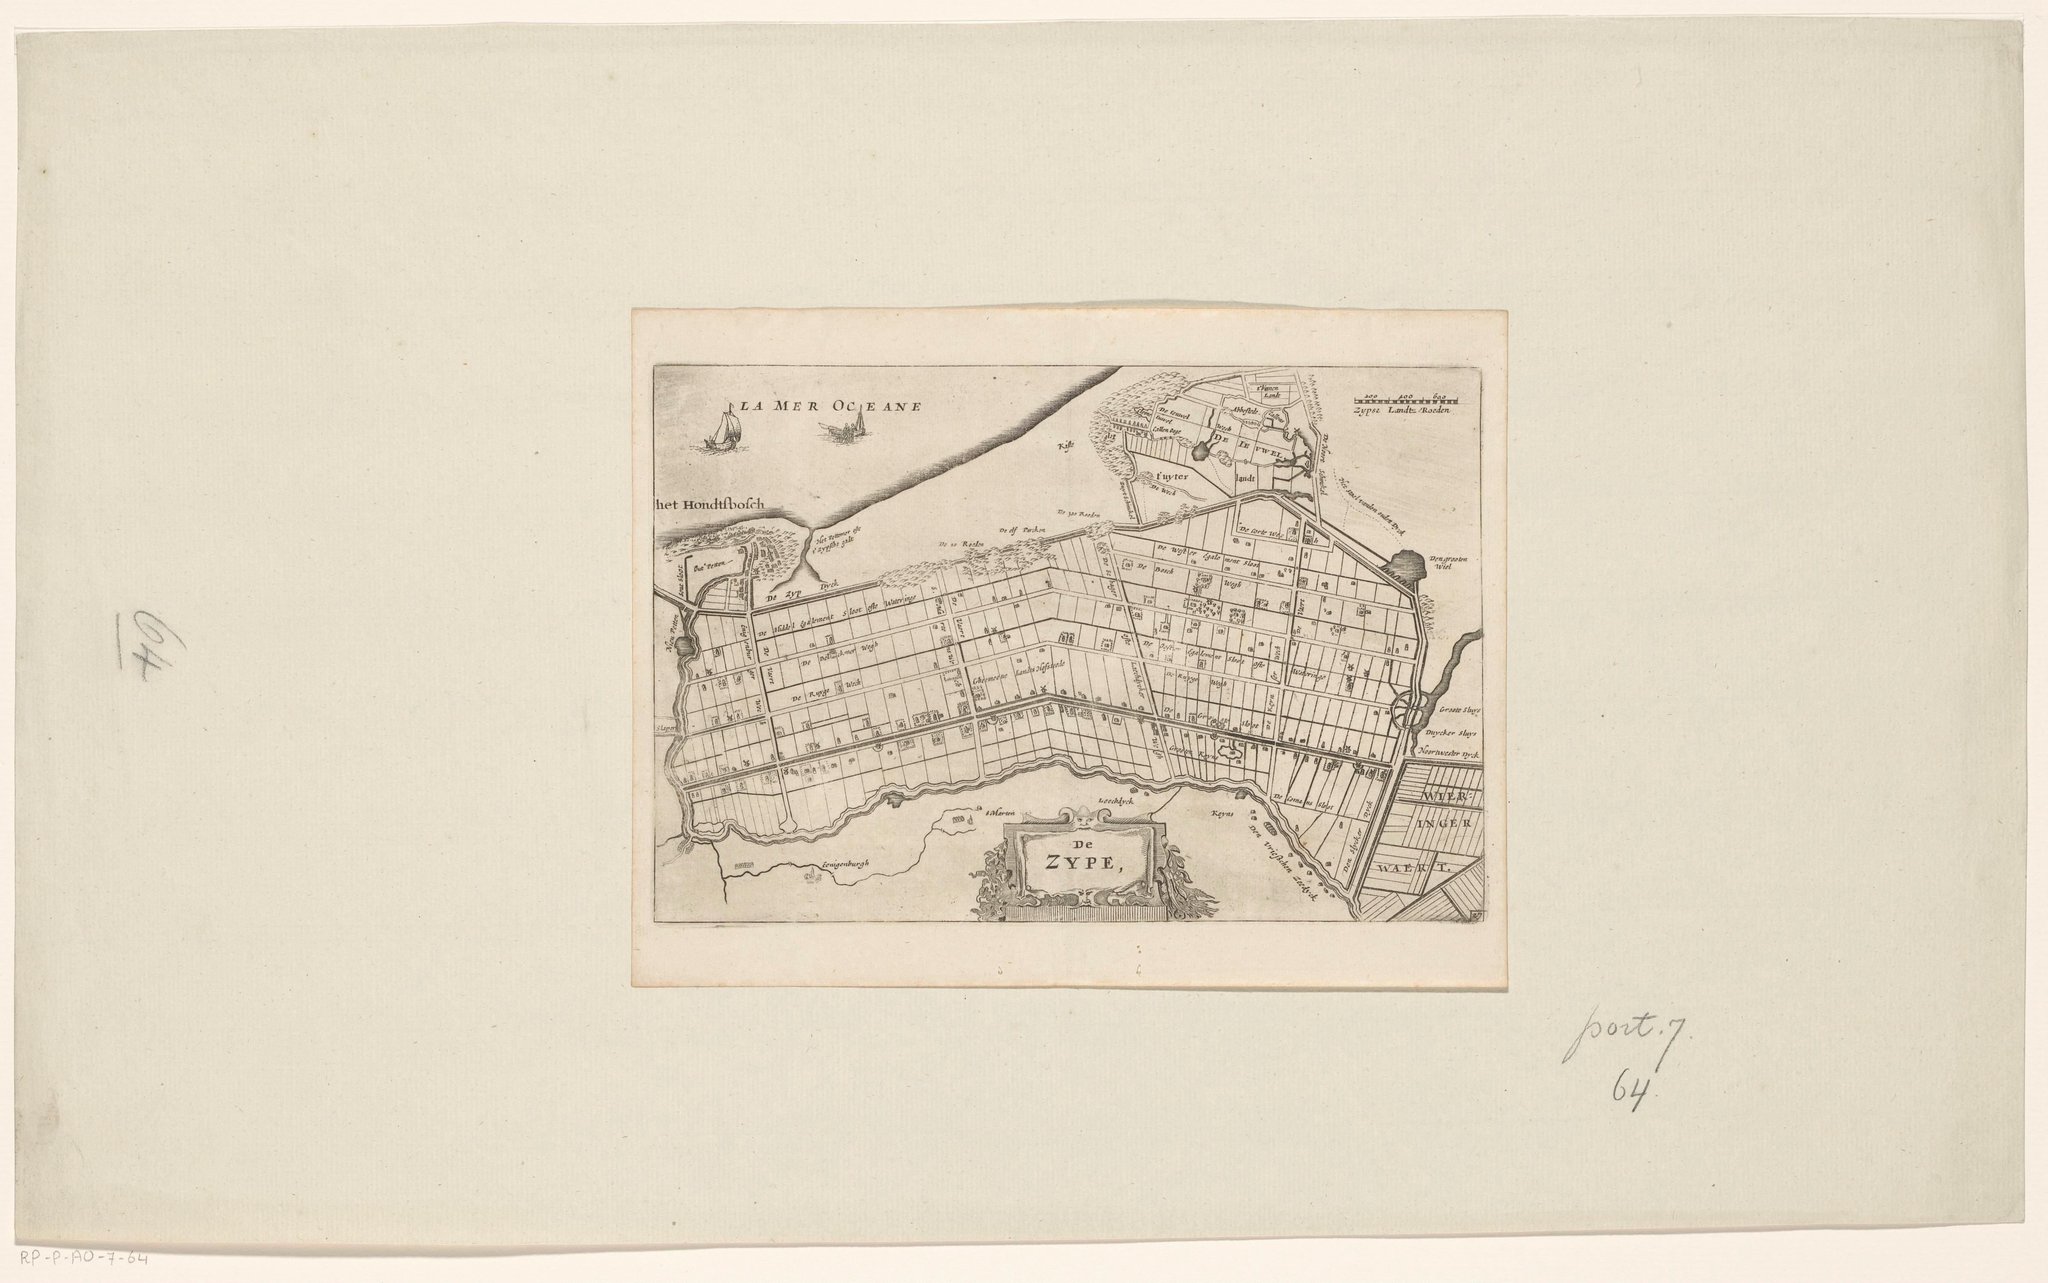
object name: map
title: Kaart van de Zijpepolder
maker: Anonymous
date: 1635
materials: paper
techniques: engraving, etching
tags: maps of separate countries or regions, polder, reclaimed land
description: Deze staat van prent ook gebruikt in: De vyerighe colom klaer vertoonende in vyftich onderscheydene curieuse caarten de XVII. Nederlantsche Provincien (…). Amsterdam: Jacob Aertsz Colom (I), s.a. [ca. 1660], tussen p. 118 en p. 119. En in latere uitgaven met de platen van deze publicatie, uitgegeven door Pieter van Alphen (1691) en Pieter van der Slaart (1696). Zie documentatie voor meer informatie. Eerdere staat van prent (zonder ‘27’ rechtsonder) ook gebruikt in eerdere drukken van deze publicatie.